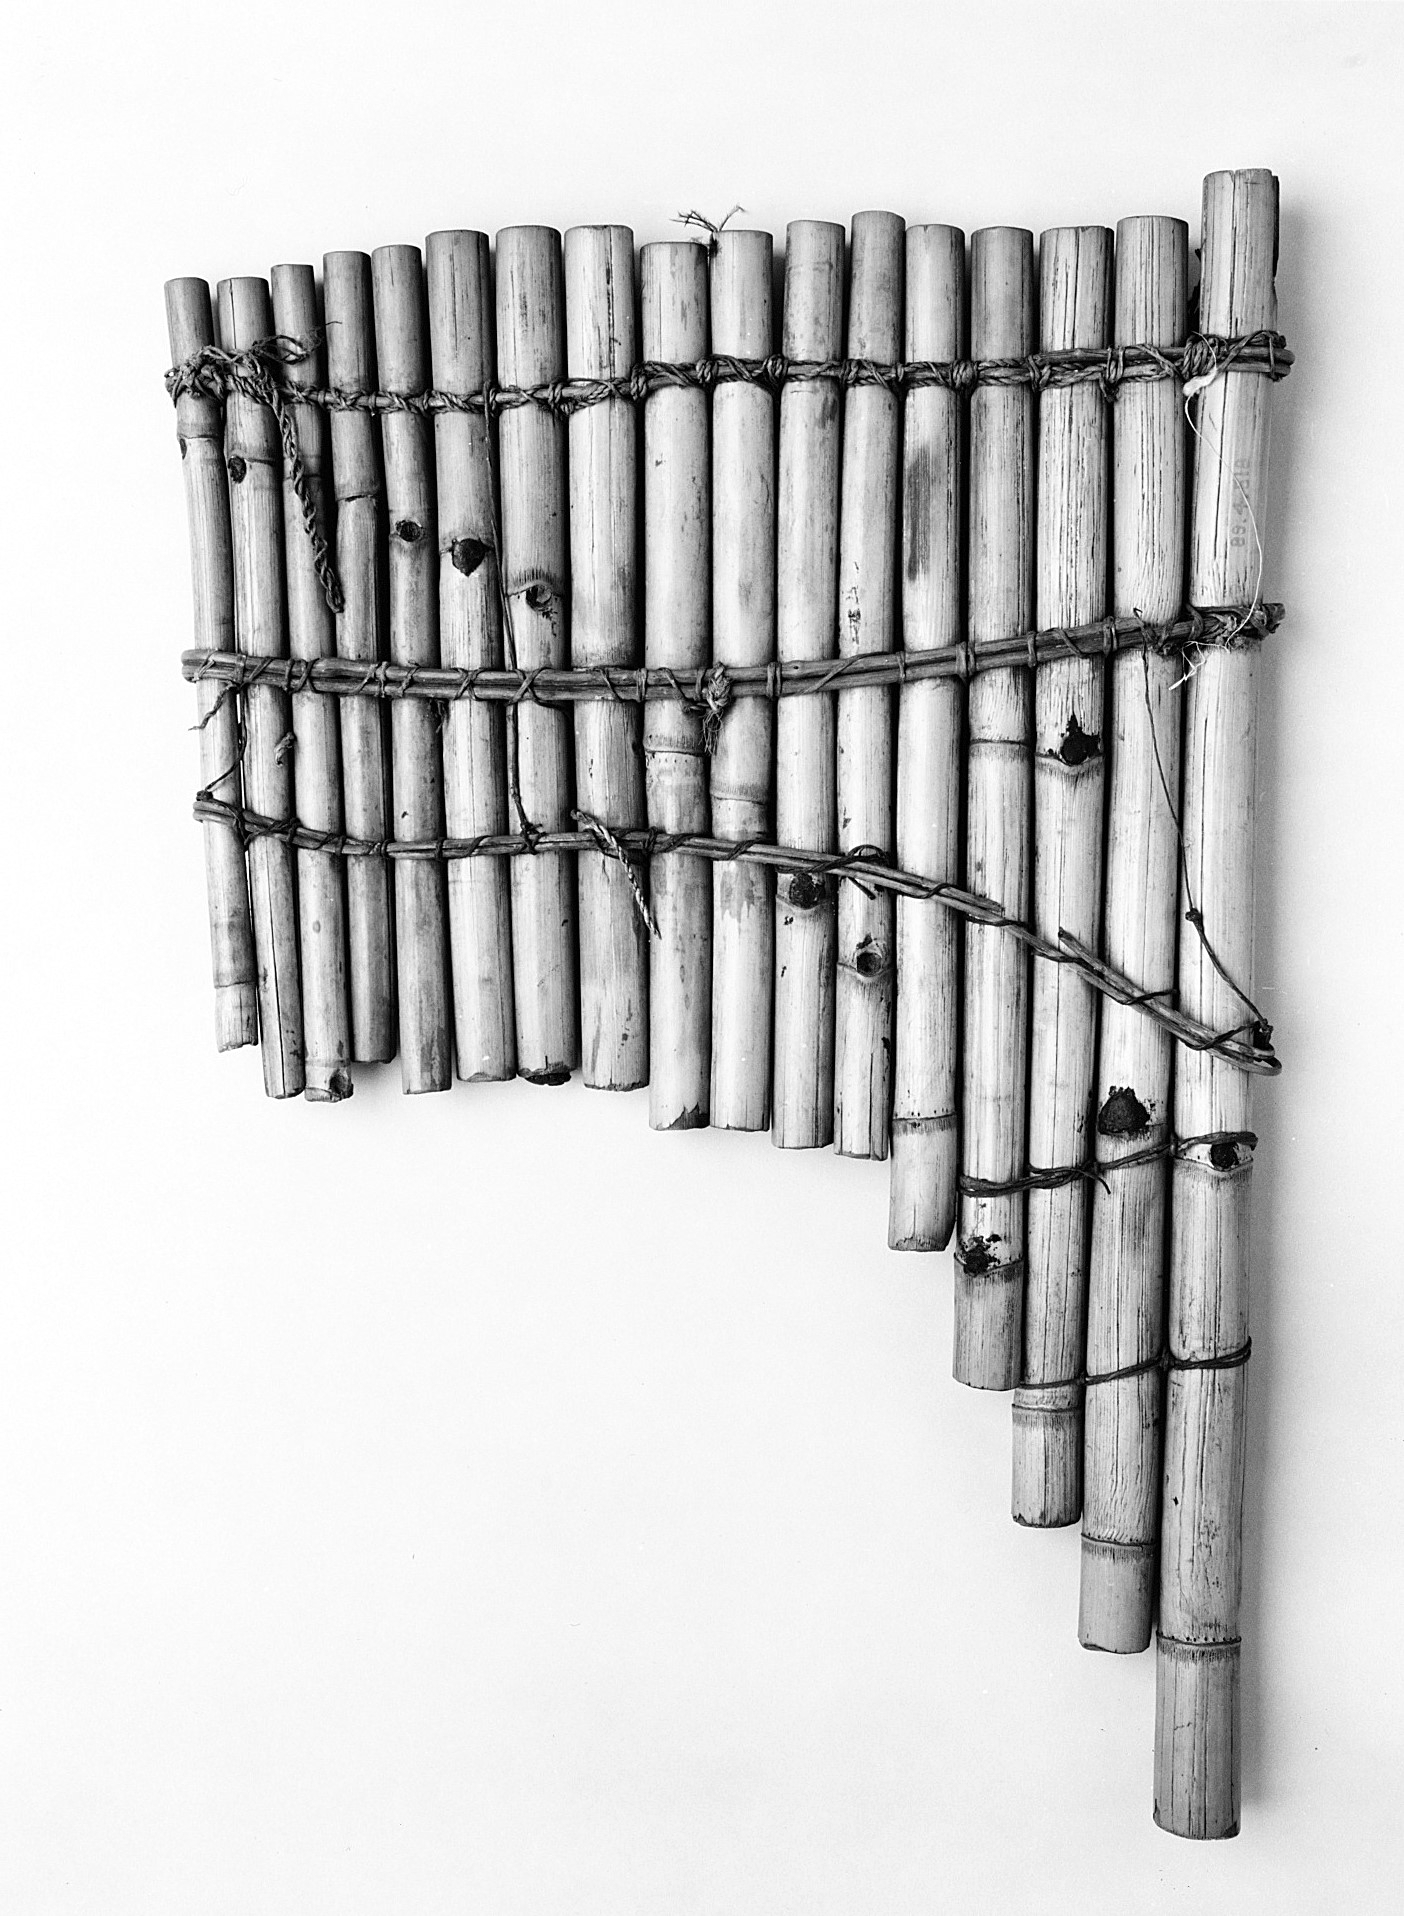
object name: enkwanzi panpipe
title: Enkwanzi (panpipe)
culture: usoga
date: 1867-1900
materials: bamboo, fiber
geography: uganda